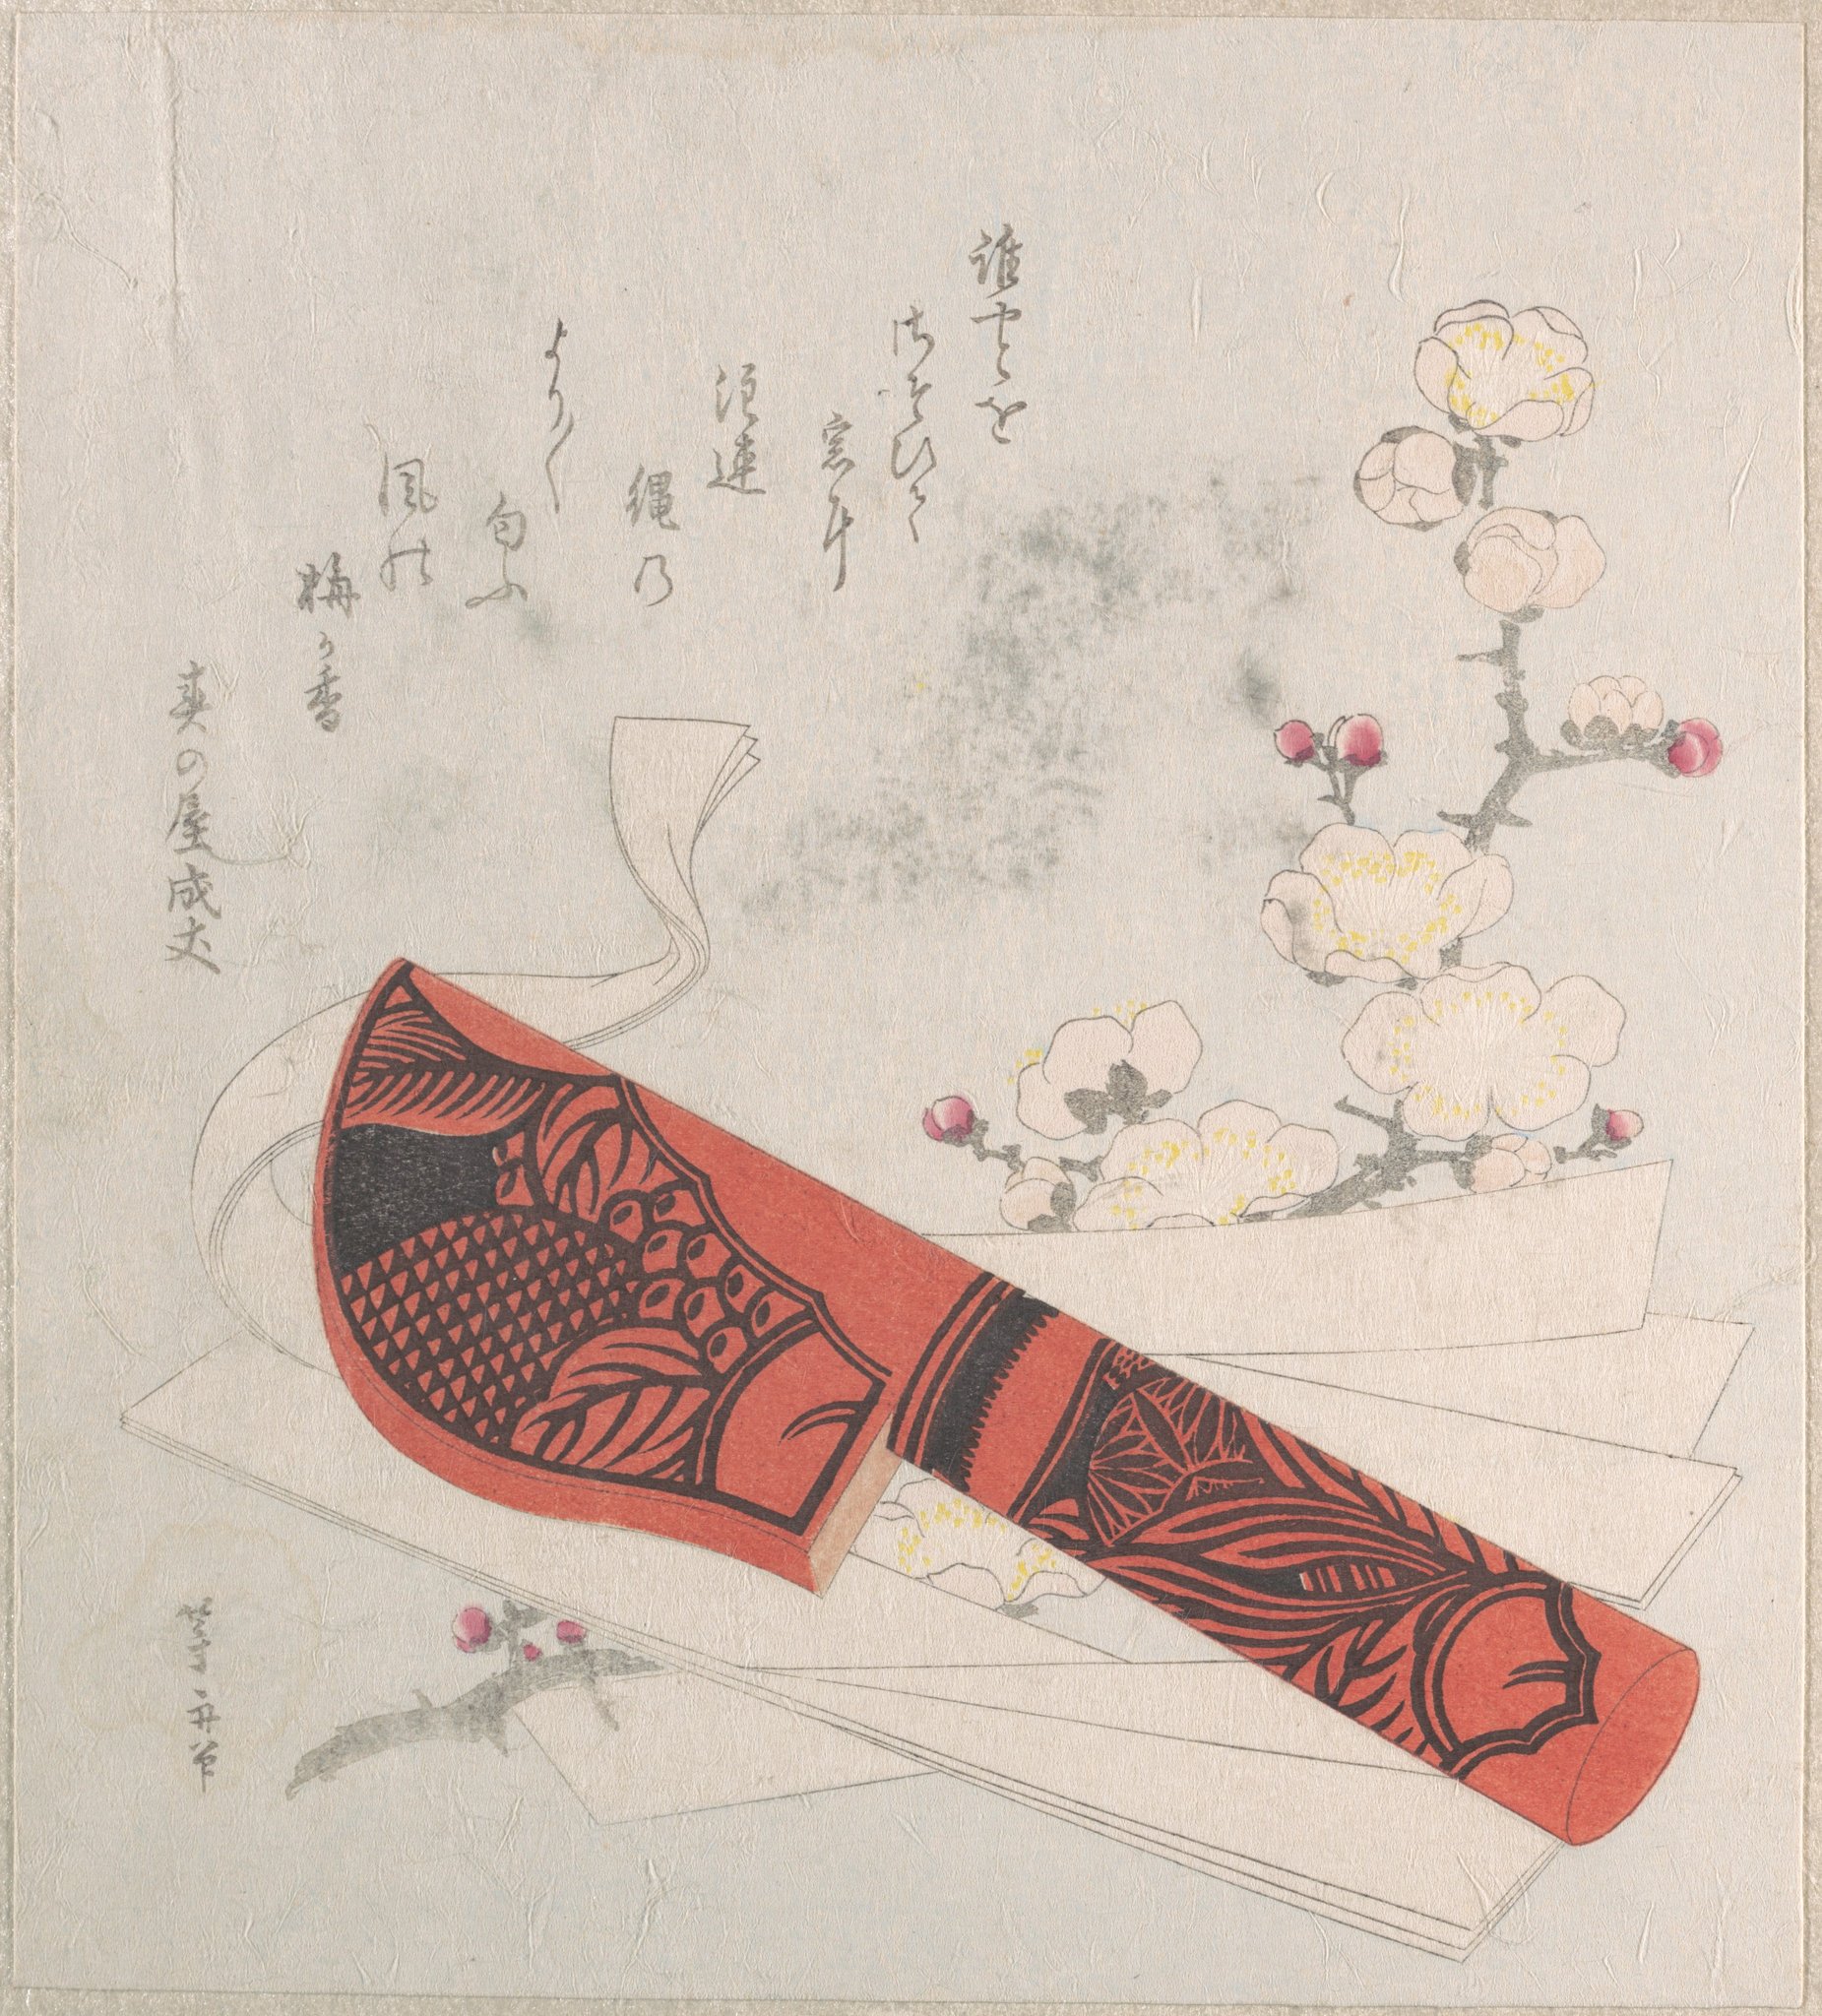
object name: print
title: Plum Blossoms, Cut Paper and a Knife in Sheath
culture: japanese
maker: uematsu tōshū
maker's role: artist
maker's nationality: japanese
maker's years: 1810-1830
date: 1615-1868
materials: ink, paper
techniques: surimono, woodblock print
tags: knives,flowers